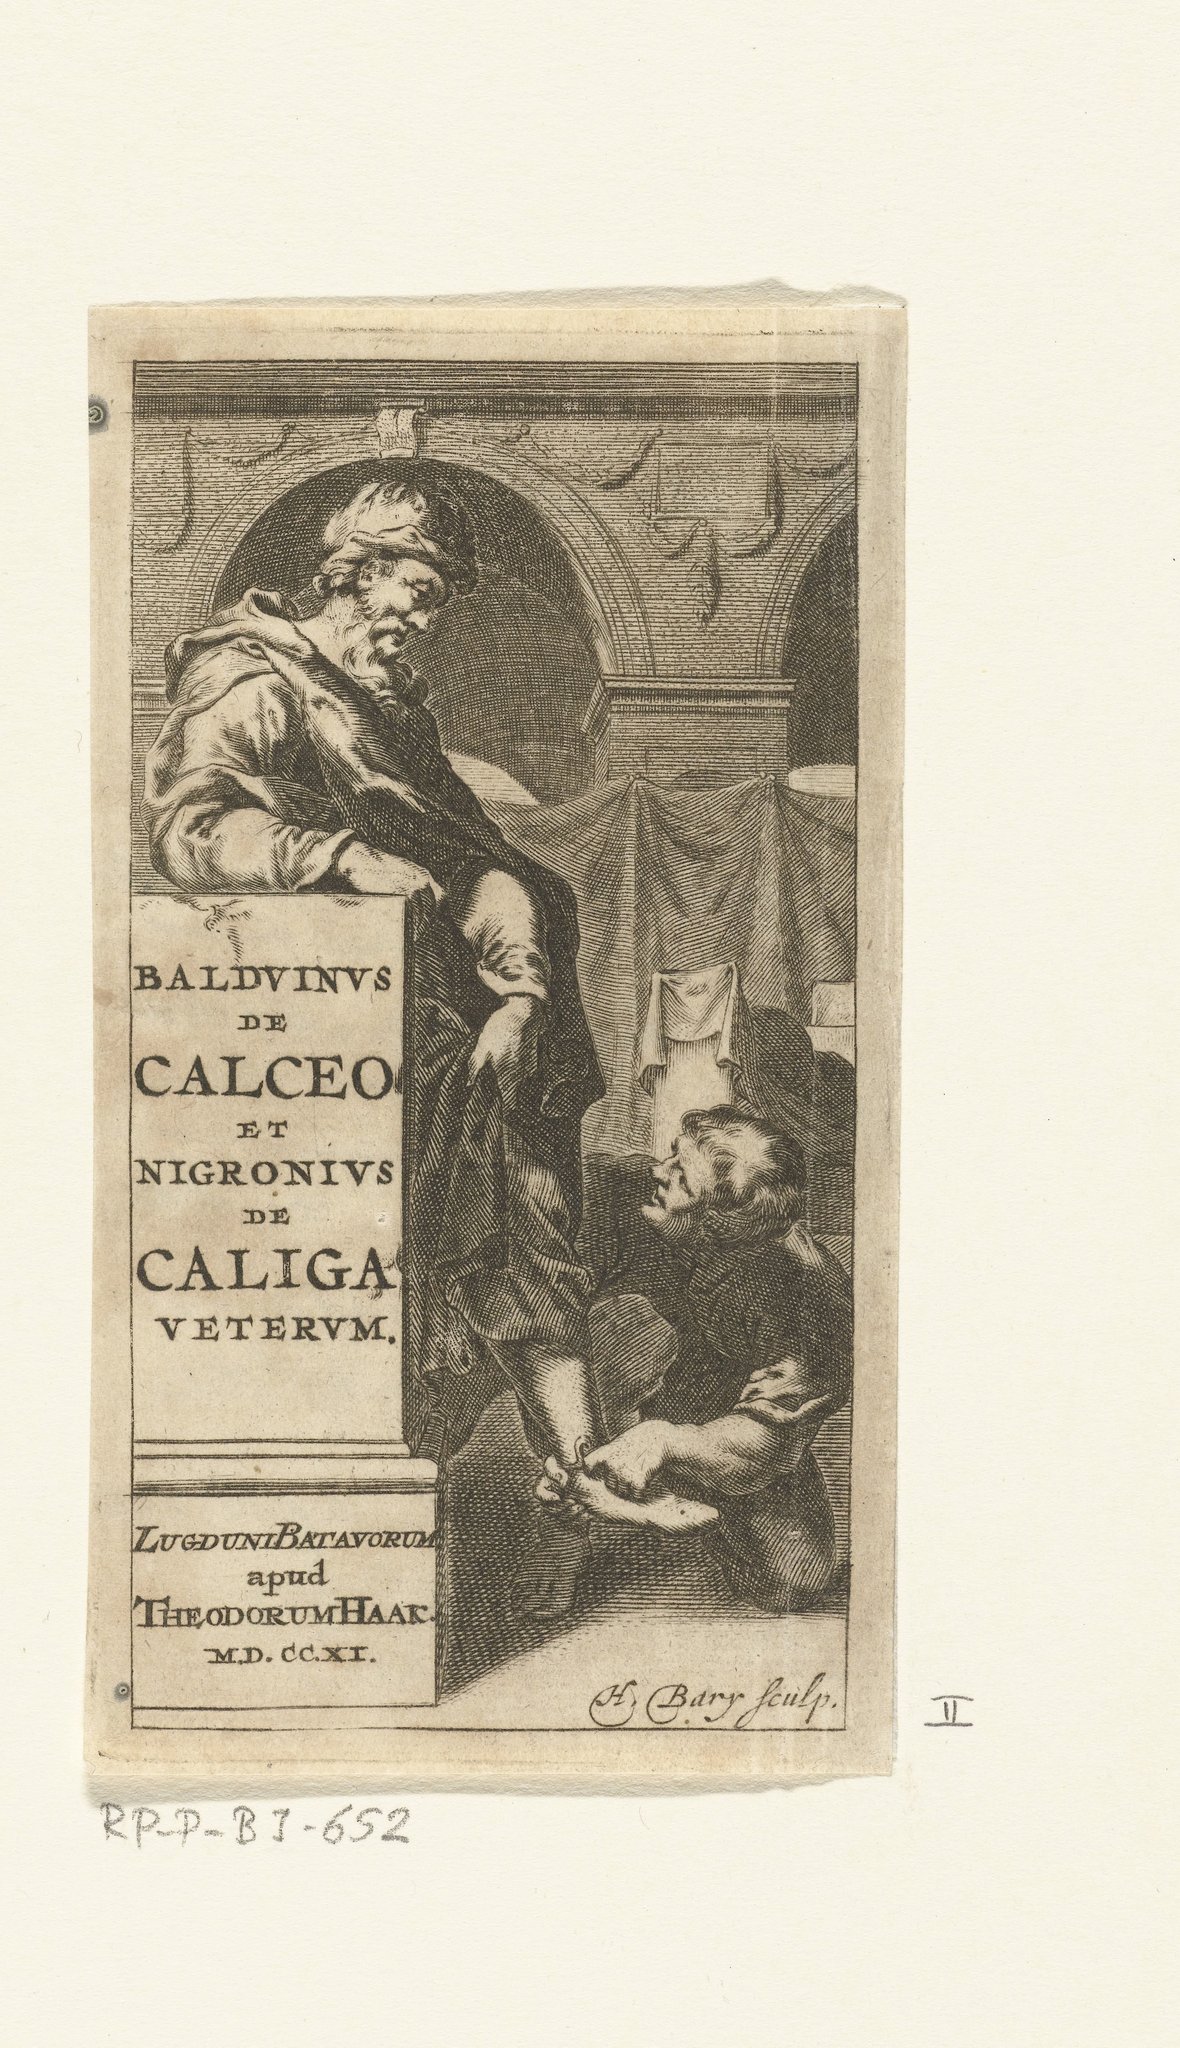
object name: titelblad, titelpagina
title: Titelpagina voor: B. Balduinus, Calceus antiquus et mysticus; J. Nigronus, De caliga veterum. Leiden, 1711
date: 1667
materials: paper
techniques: engraving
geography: leiden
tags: putting on (tying) or taking off (untying) sandals or shoes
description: Titelpagina voor: B. Balduinus, Calceus antiquus et mysticus; J. Nigronus, De caliga veterum. Leiden, D. Haak, 1711